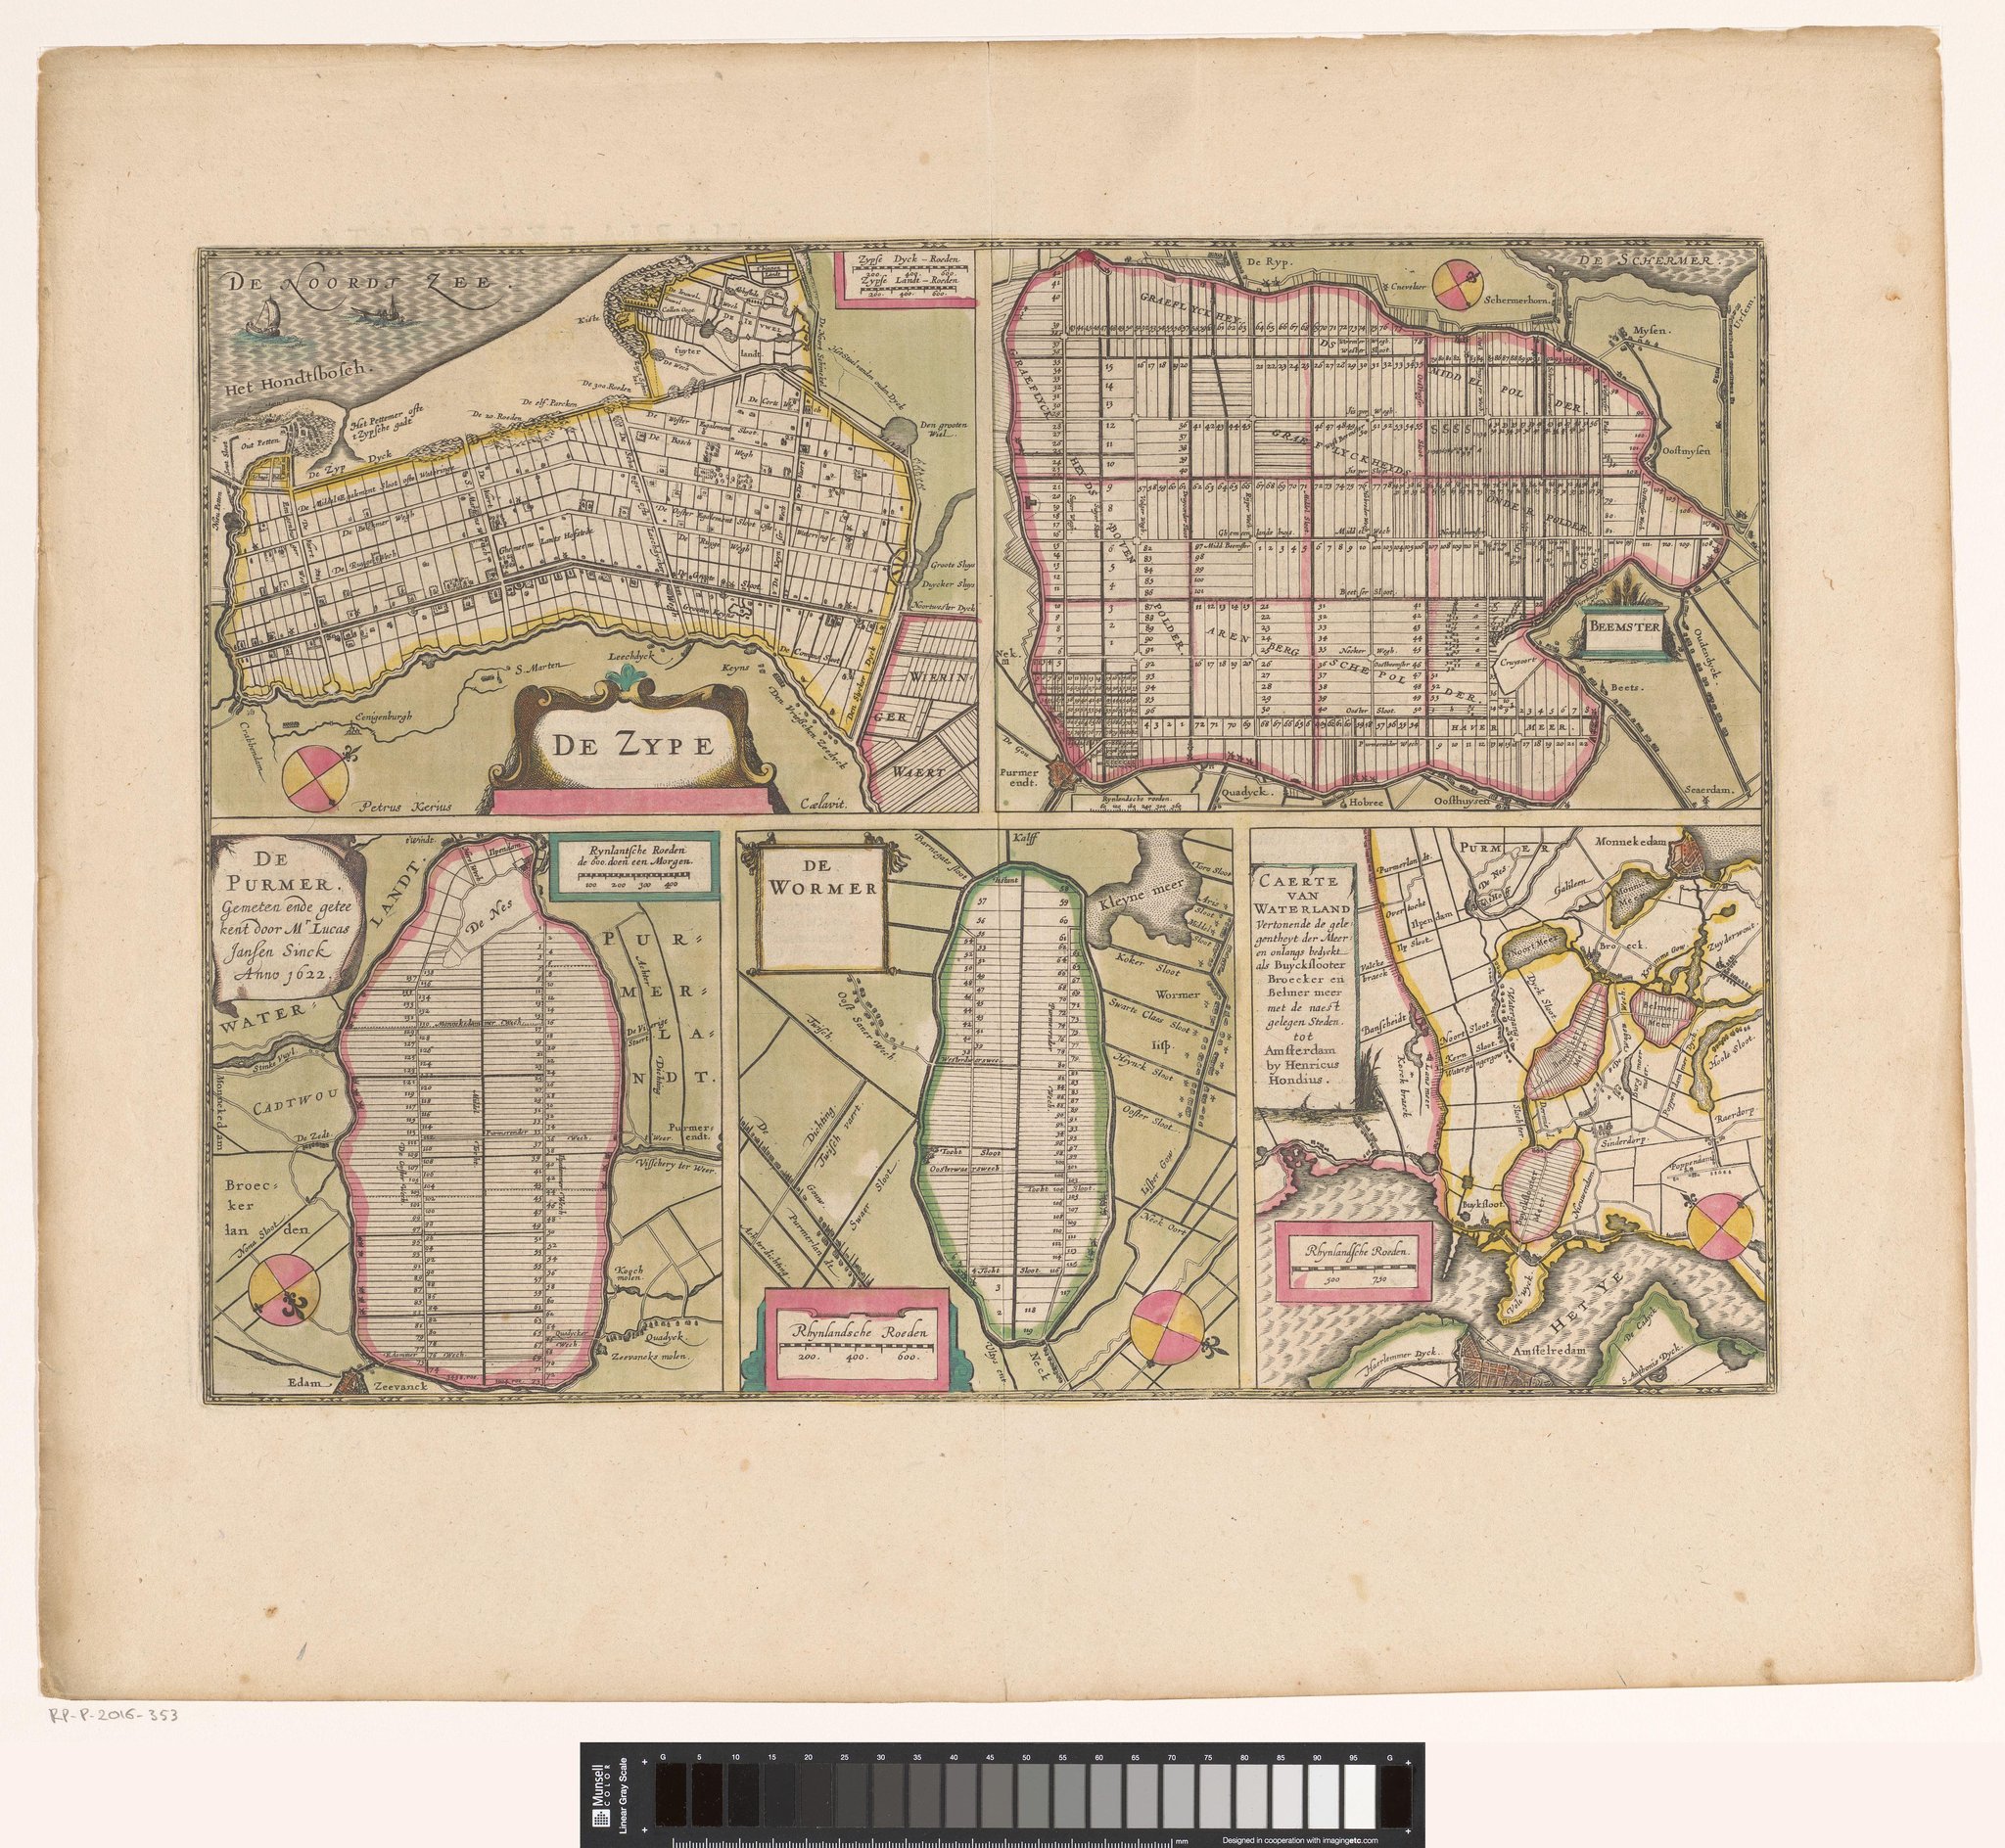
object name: map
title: De Zype / Beemster / De Purmer / De Wormer / Caerte van Waterland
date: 1631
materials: paper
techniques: engraving, etching, hand coloring, letterpress printing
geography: amsterdam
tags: maps of separate countries or regions, polder, reclaimed land, beemster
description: Blad met vijf kaarten van bedijkte en verkavelde polders. Linksboven de Zijpe (1597) met daarop rechts de Wieringerwaard en rechtsboven twee schaalstokken: Zypse dyck-roeden; Zypse landt-roeden. Rechtsboven de Beemster (1612) met daarop linksonder een schaalstok: Rynlandsche roeden. Linksonder de Purmer (1622) met daarop rechtsboven een schaalstok: Rynlantsche roeden de 600 doen een morgen. Onder in het midden de Wormer (1626) met daarop linksonder een schaalstok: Rhynlandsche roeden. Rechtsonder een kaart van Waterland met daarop de polders van het Buikslotermeer, Broekermeer en Belmermeer (1628) en linksonder een schaalstok: Rhynlandsche roeden. Op verso Latijnse tekst.